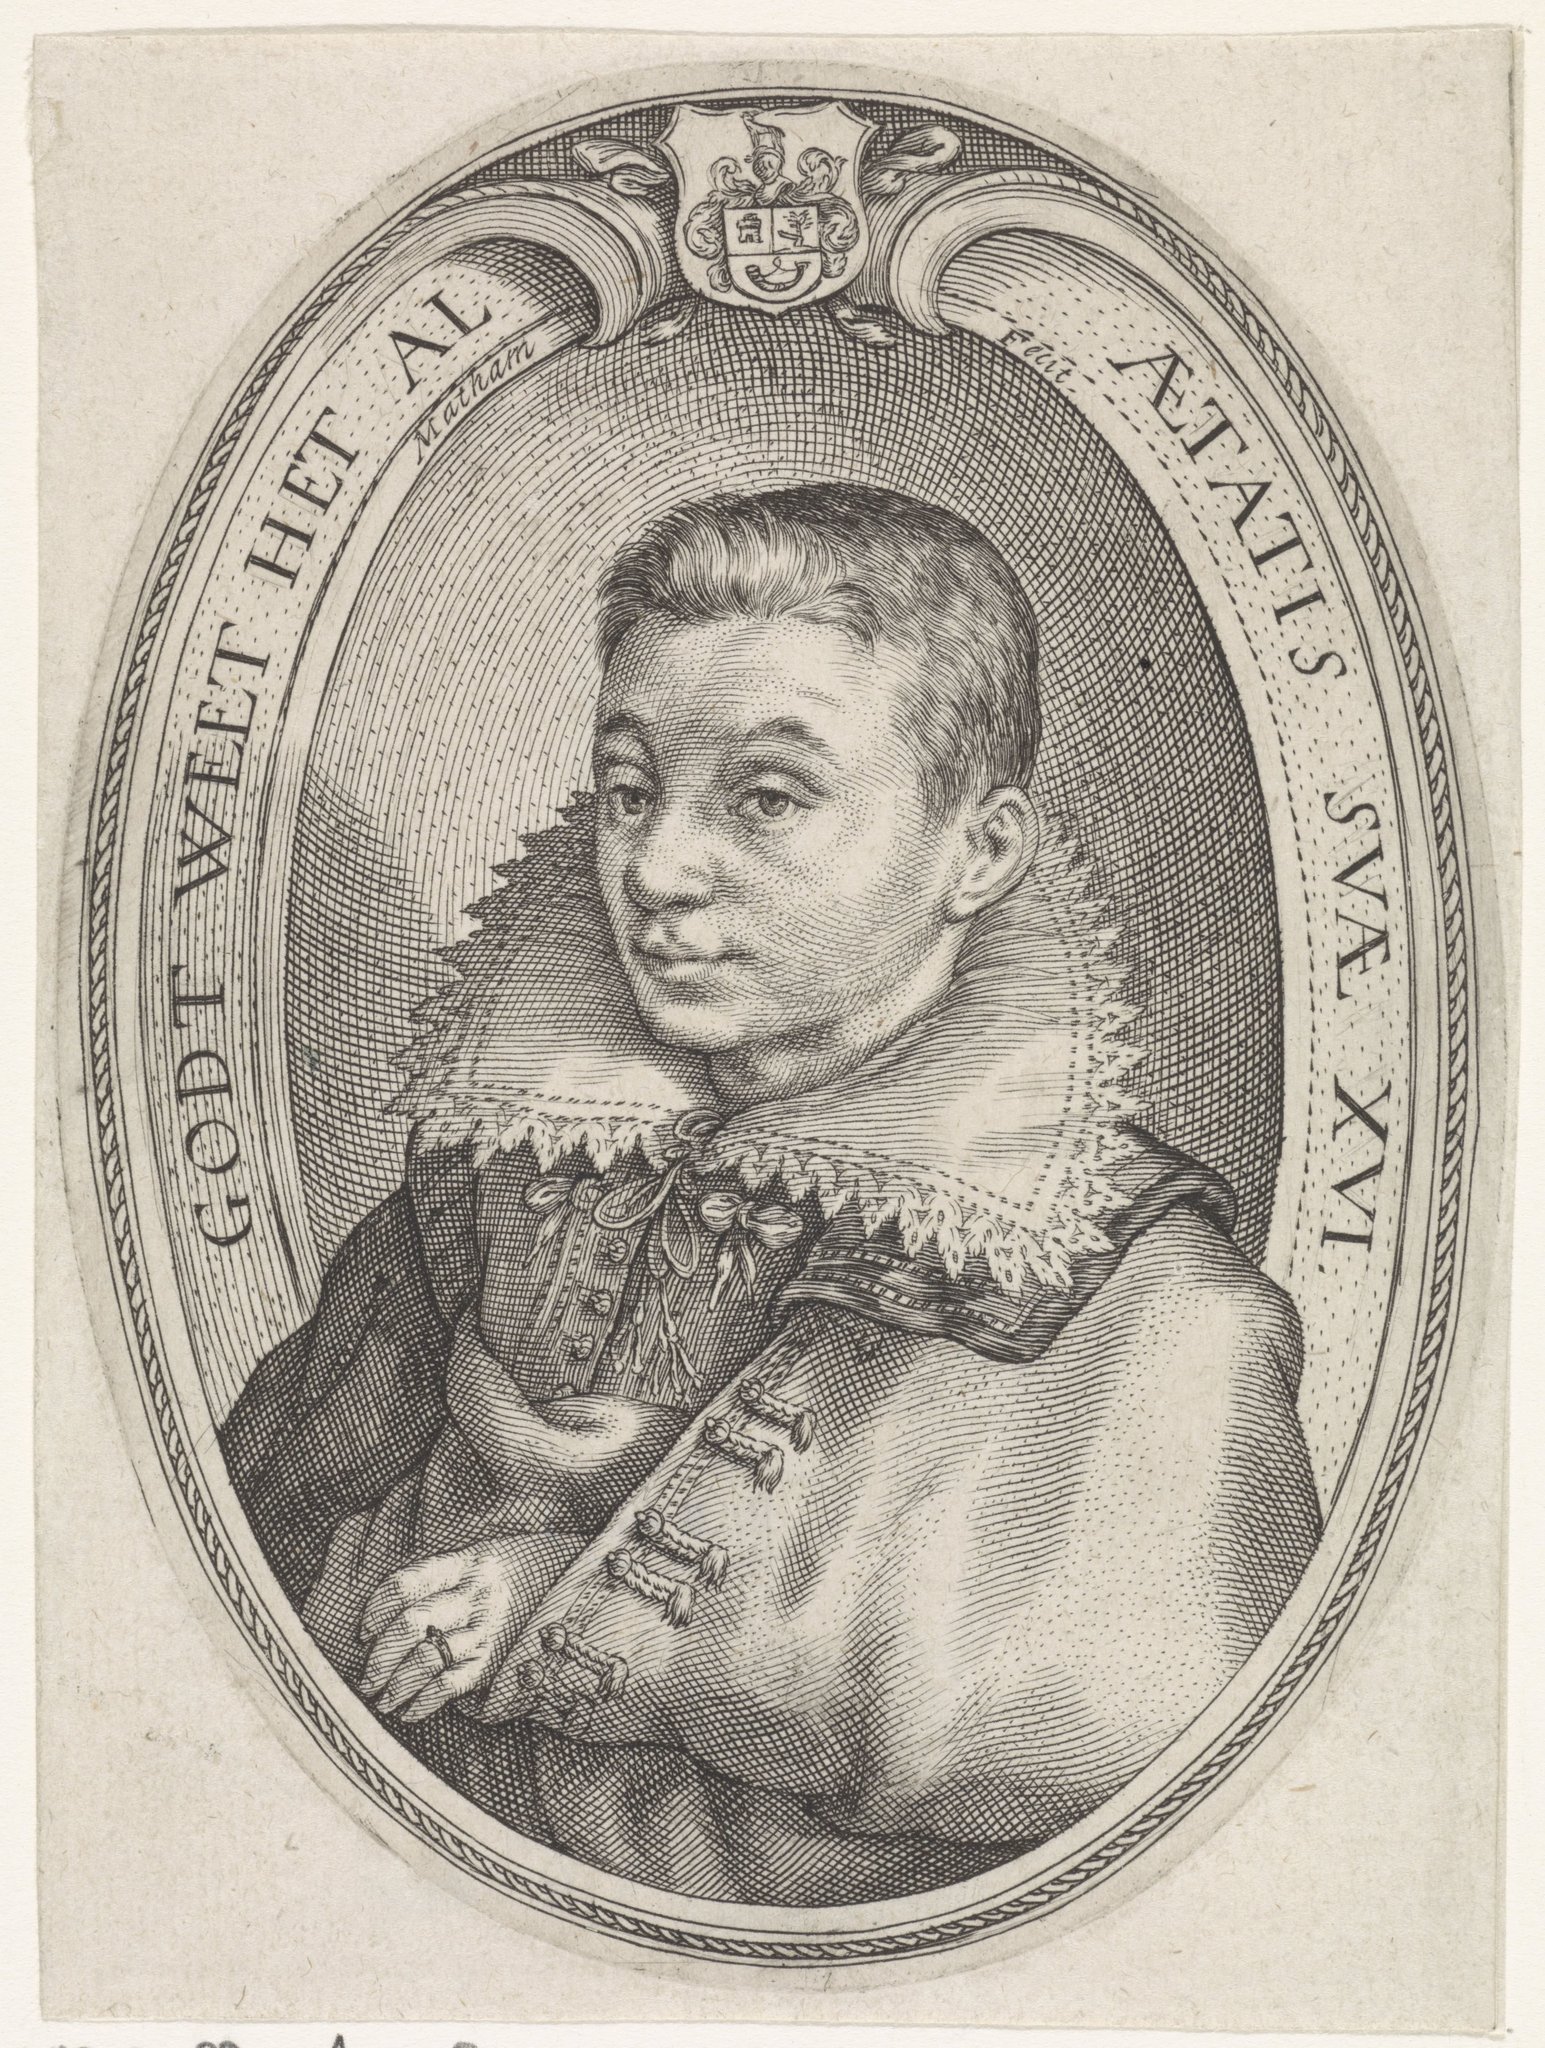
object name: print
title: Portret van Cornelis Abrahamsz. van Hoorn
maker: jacob matham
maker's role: draughtsman, print maker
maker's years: 1571-1631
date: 1611-1615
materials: paper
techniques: engraving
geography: haarlem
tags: haarlem, historical persons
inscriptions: collector's mark: Lugt 2228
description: Portret van Cornelis Abrahamsz. van Hoorn op 16-jarige leeftijd.